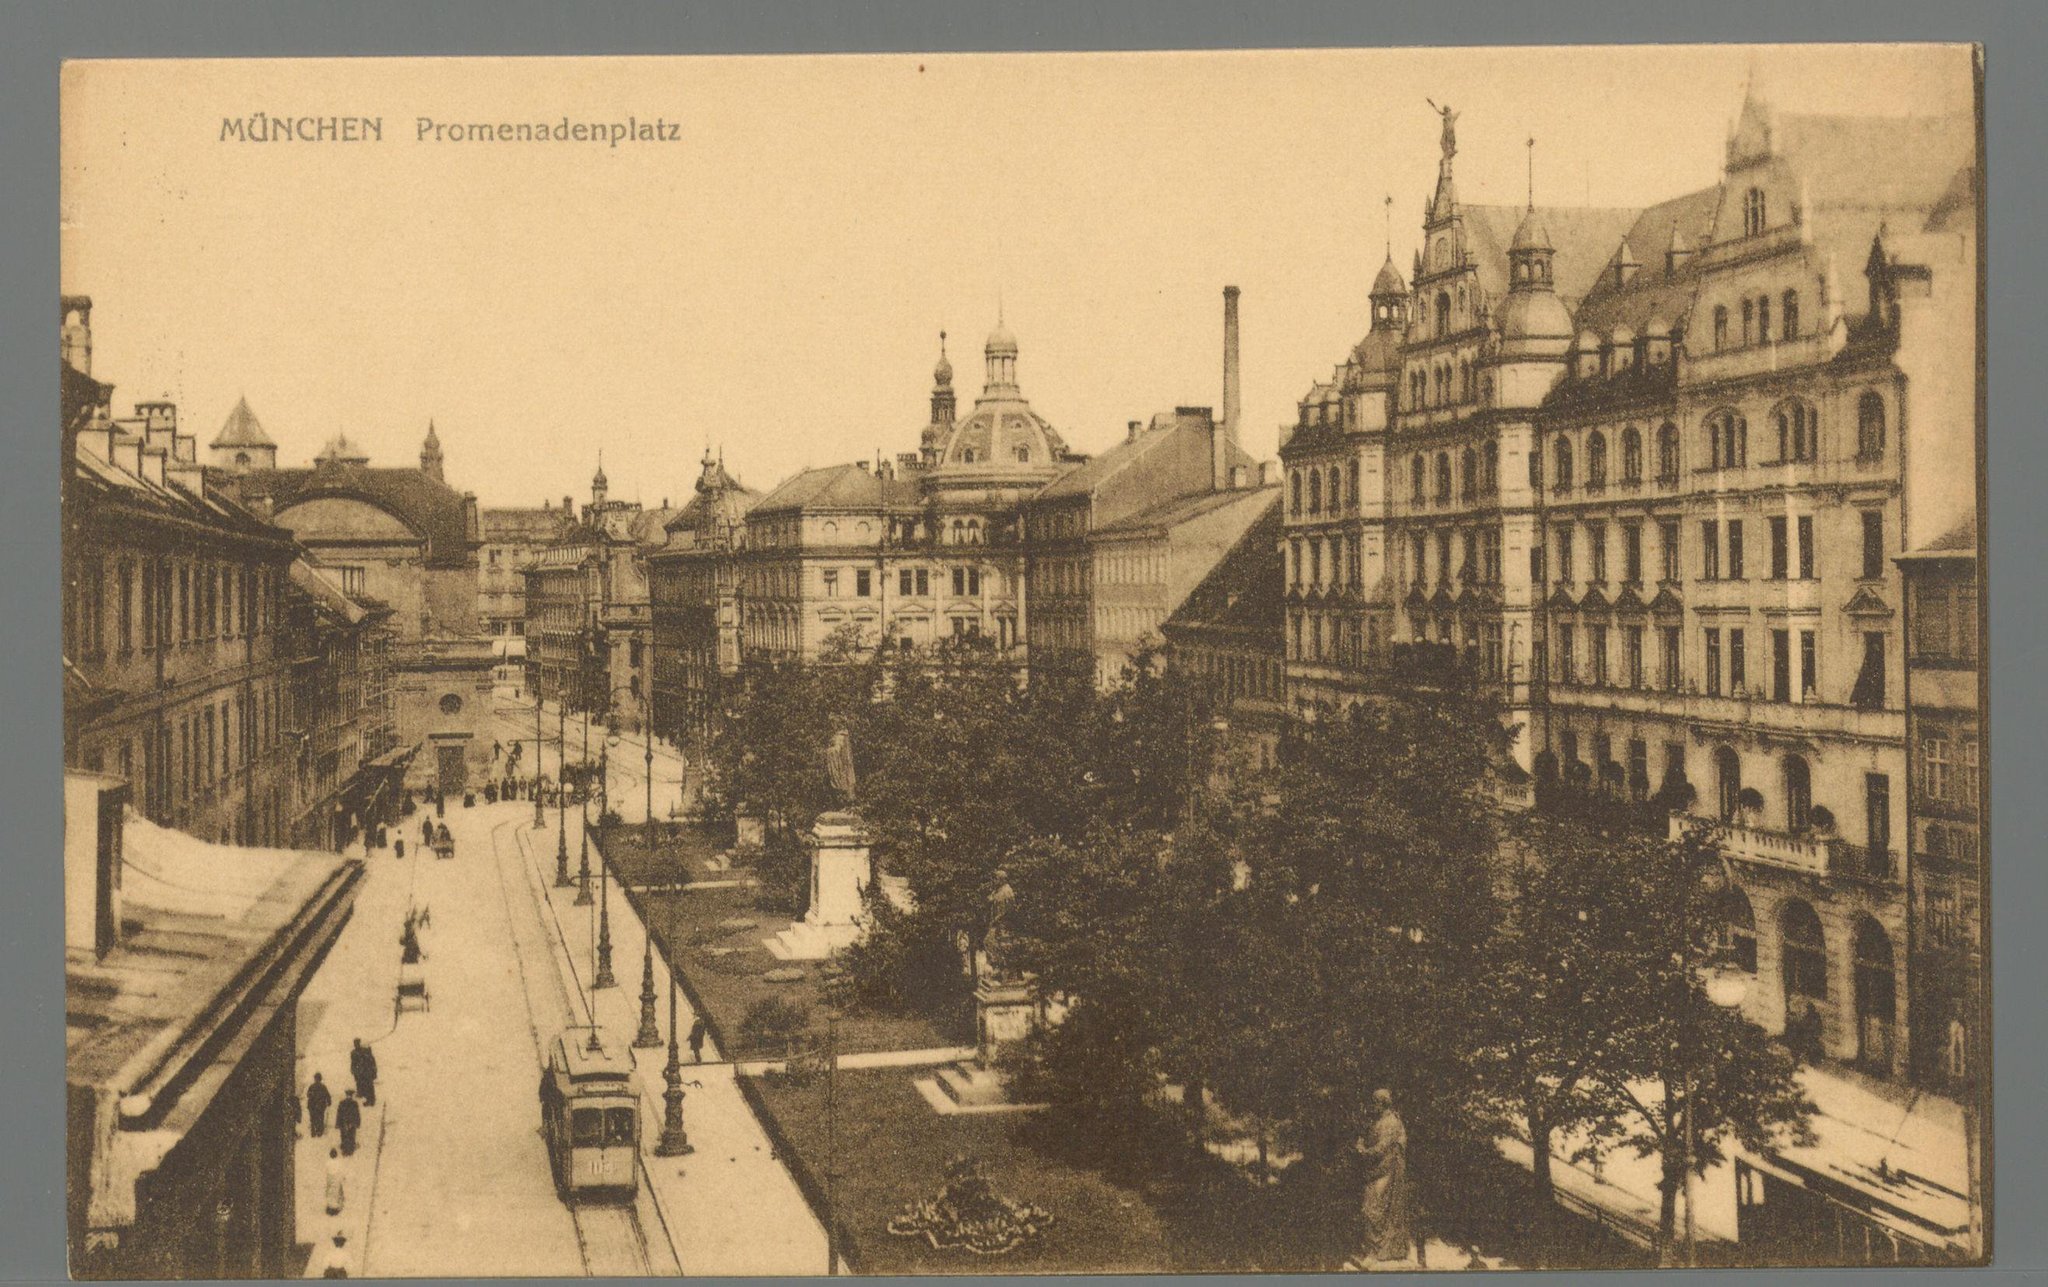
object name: photomechanical print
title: München. Promenadenplatz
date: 1905-1930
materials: cardboard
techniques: photograph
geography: munich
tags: square, place, circus, etc., street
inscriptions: inscription: ‘W.H.D.’